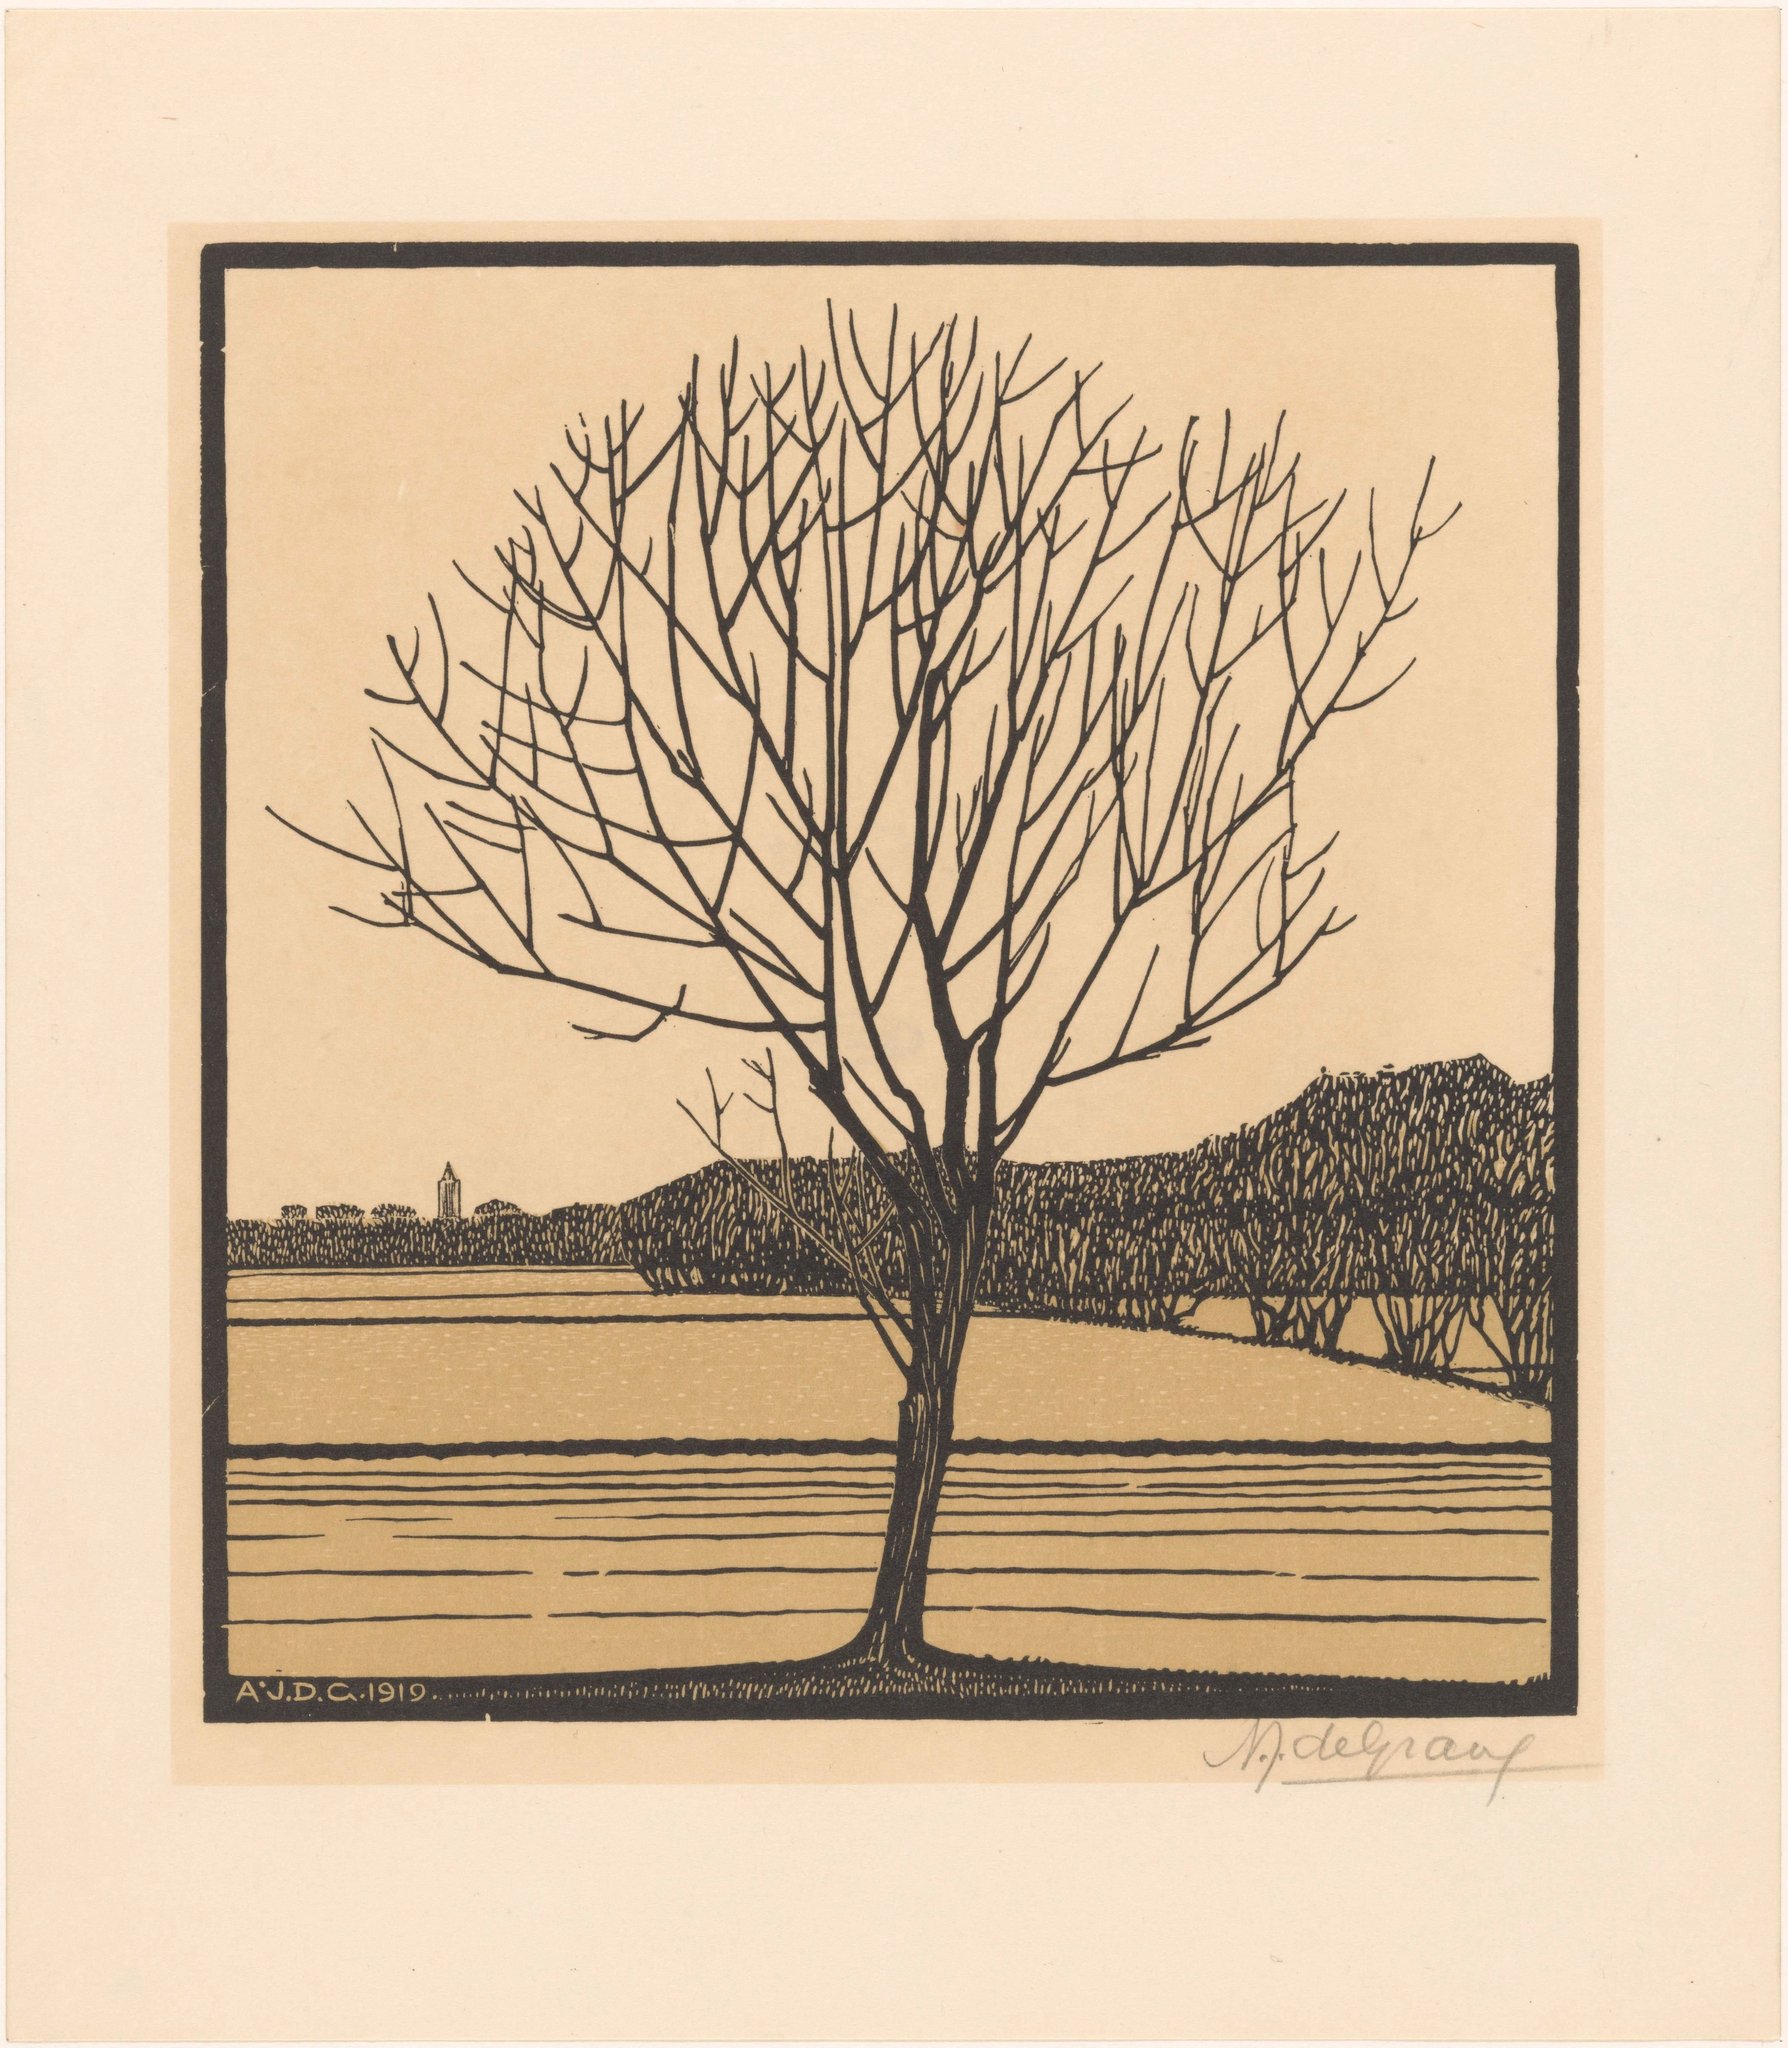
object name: print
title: Kale boom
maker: julie de graag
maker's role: draughtsman, print maker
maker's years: 1877-1924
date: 1919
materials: paper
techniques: woodcut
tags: trees (+ bare plant), cultivated land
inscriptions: collector's mark: Lugt 2228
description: Op de achtergrond een landschap met akkers, struiken en een kerktoren.